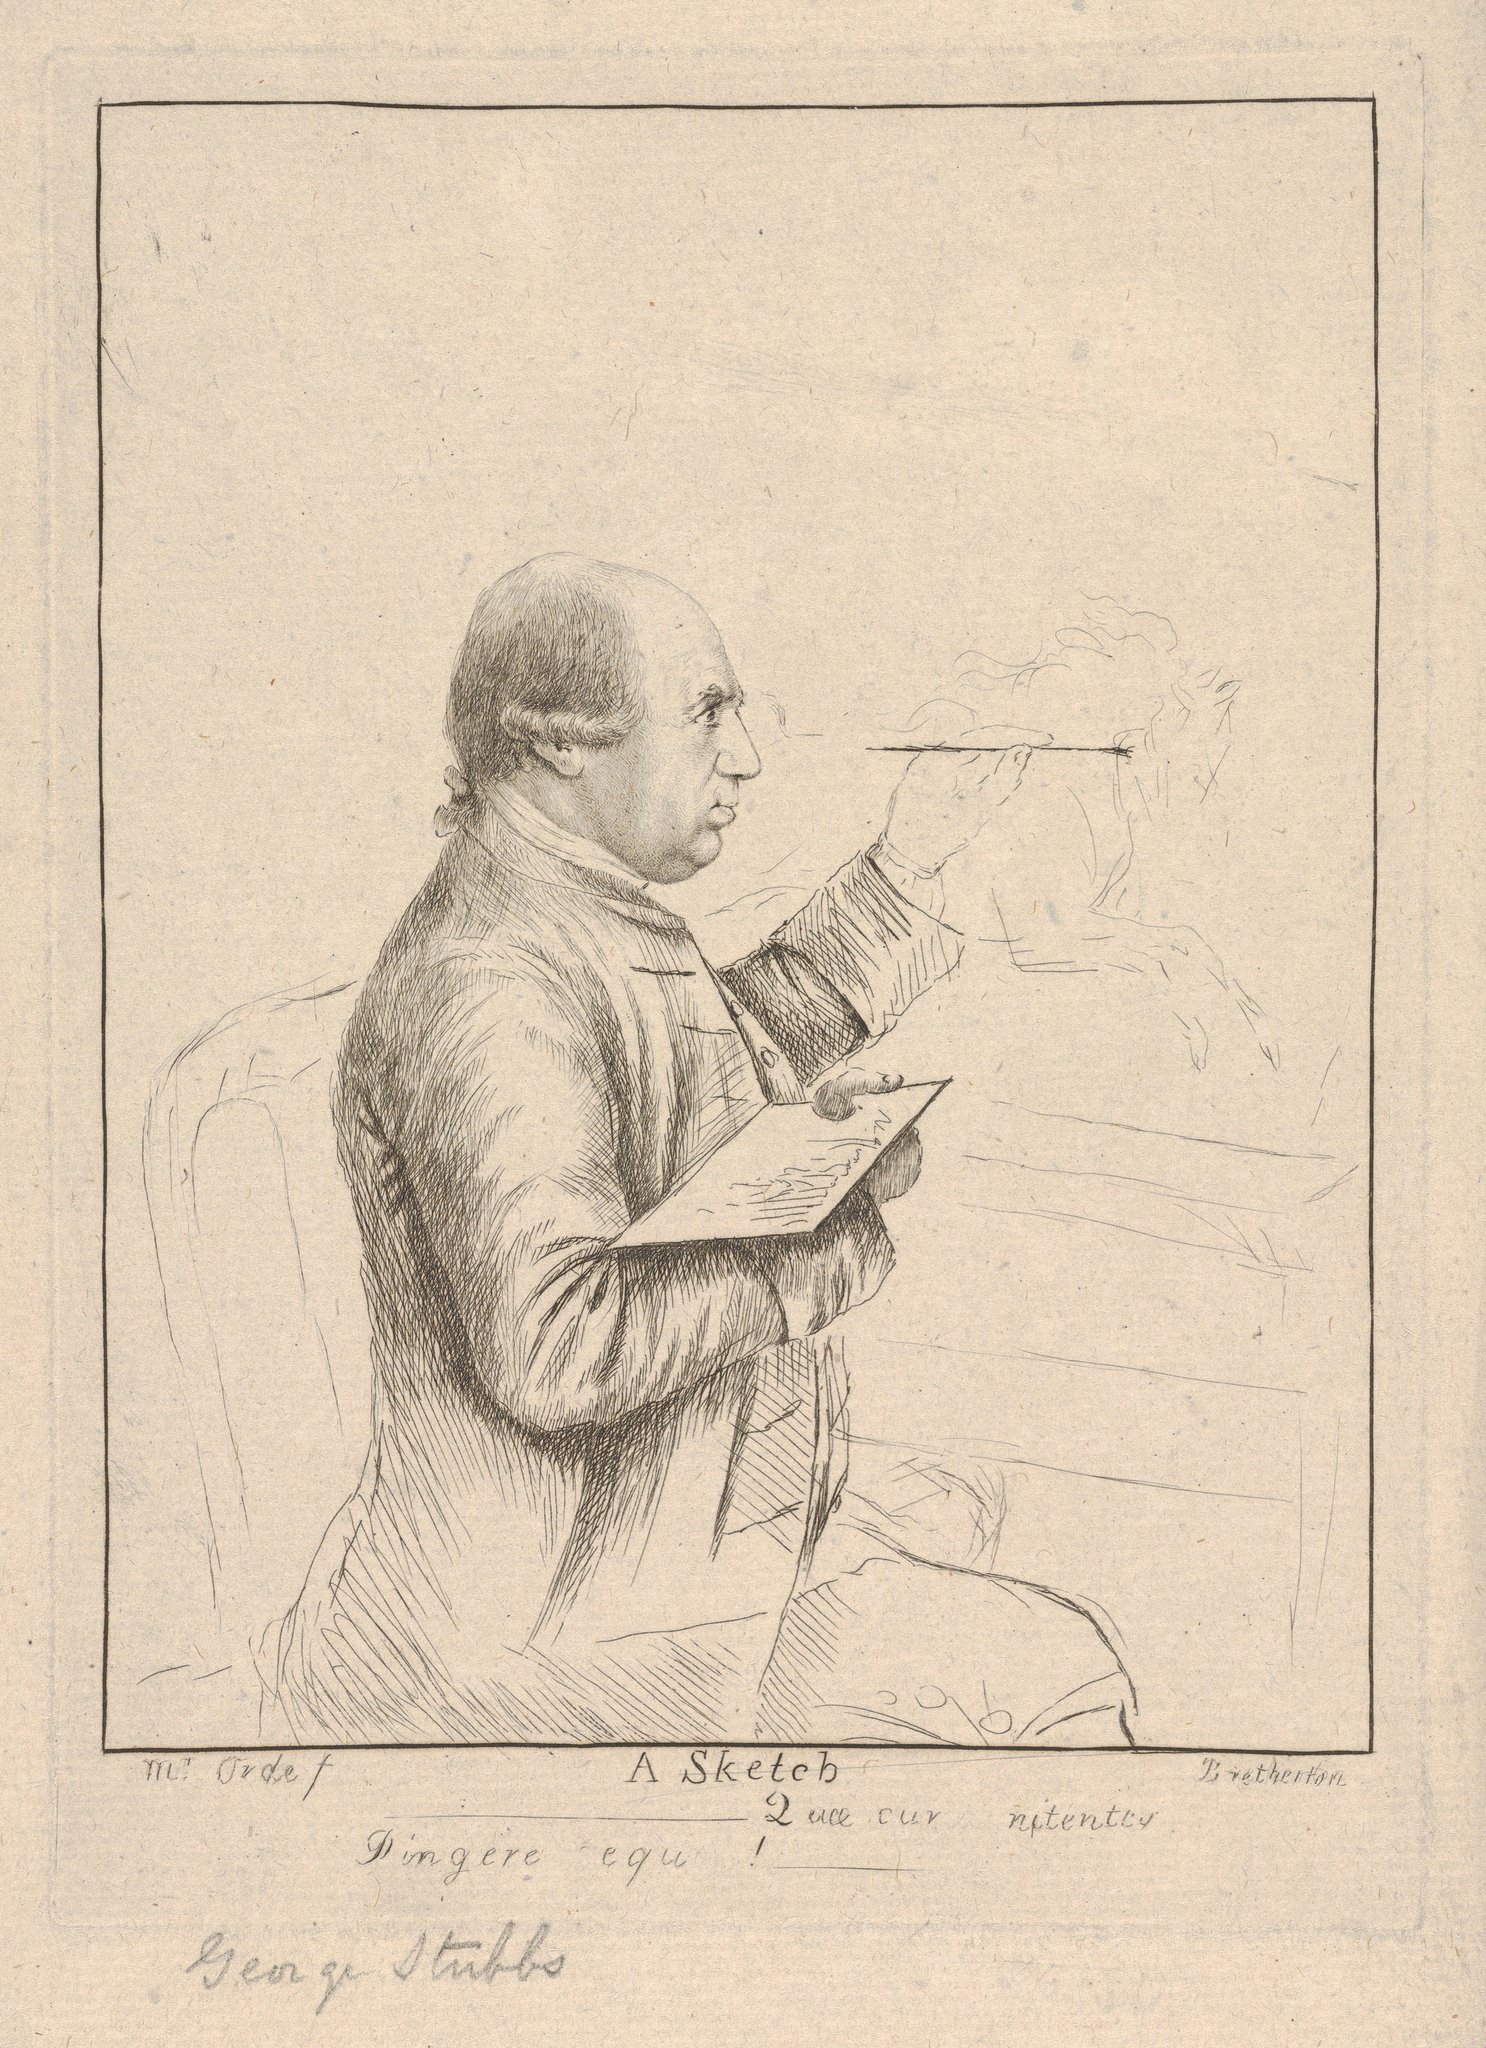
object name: print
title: A Sketch (Portrait of George Stubbs)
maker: james bretherton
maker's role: artist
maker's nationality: british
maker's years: 1750-1799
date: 1751-1800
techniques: etching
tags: painting,men,artists